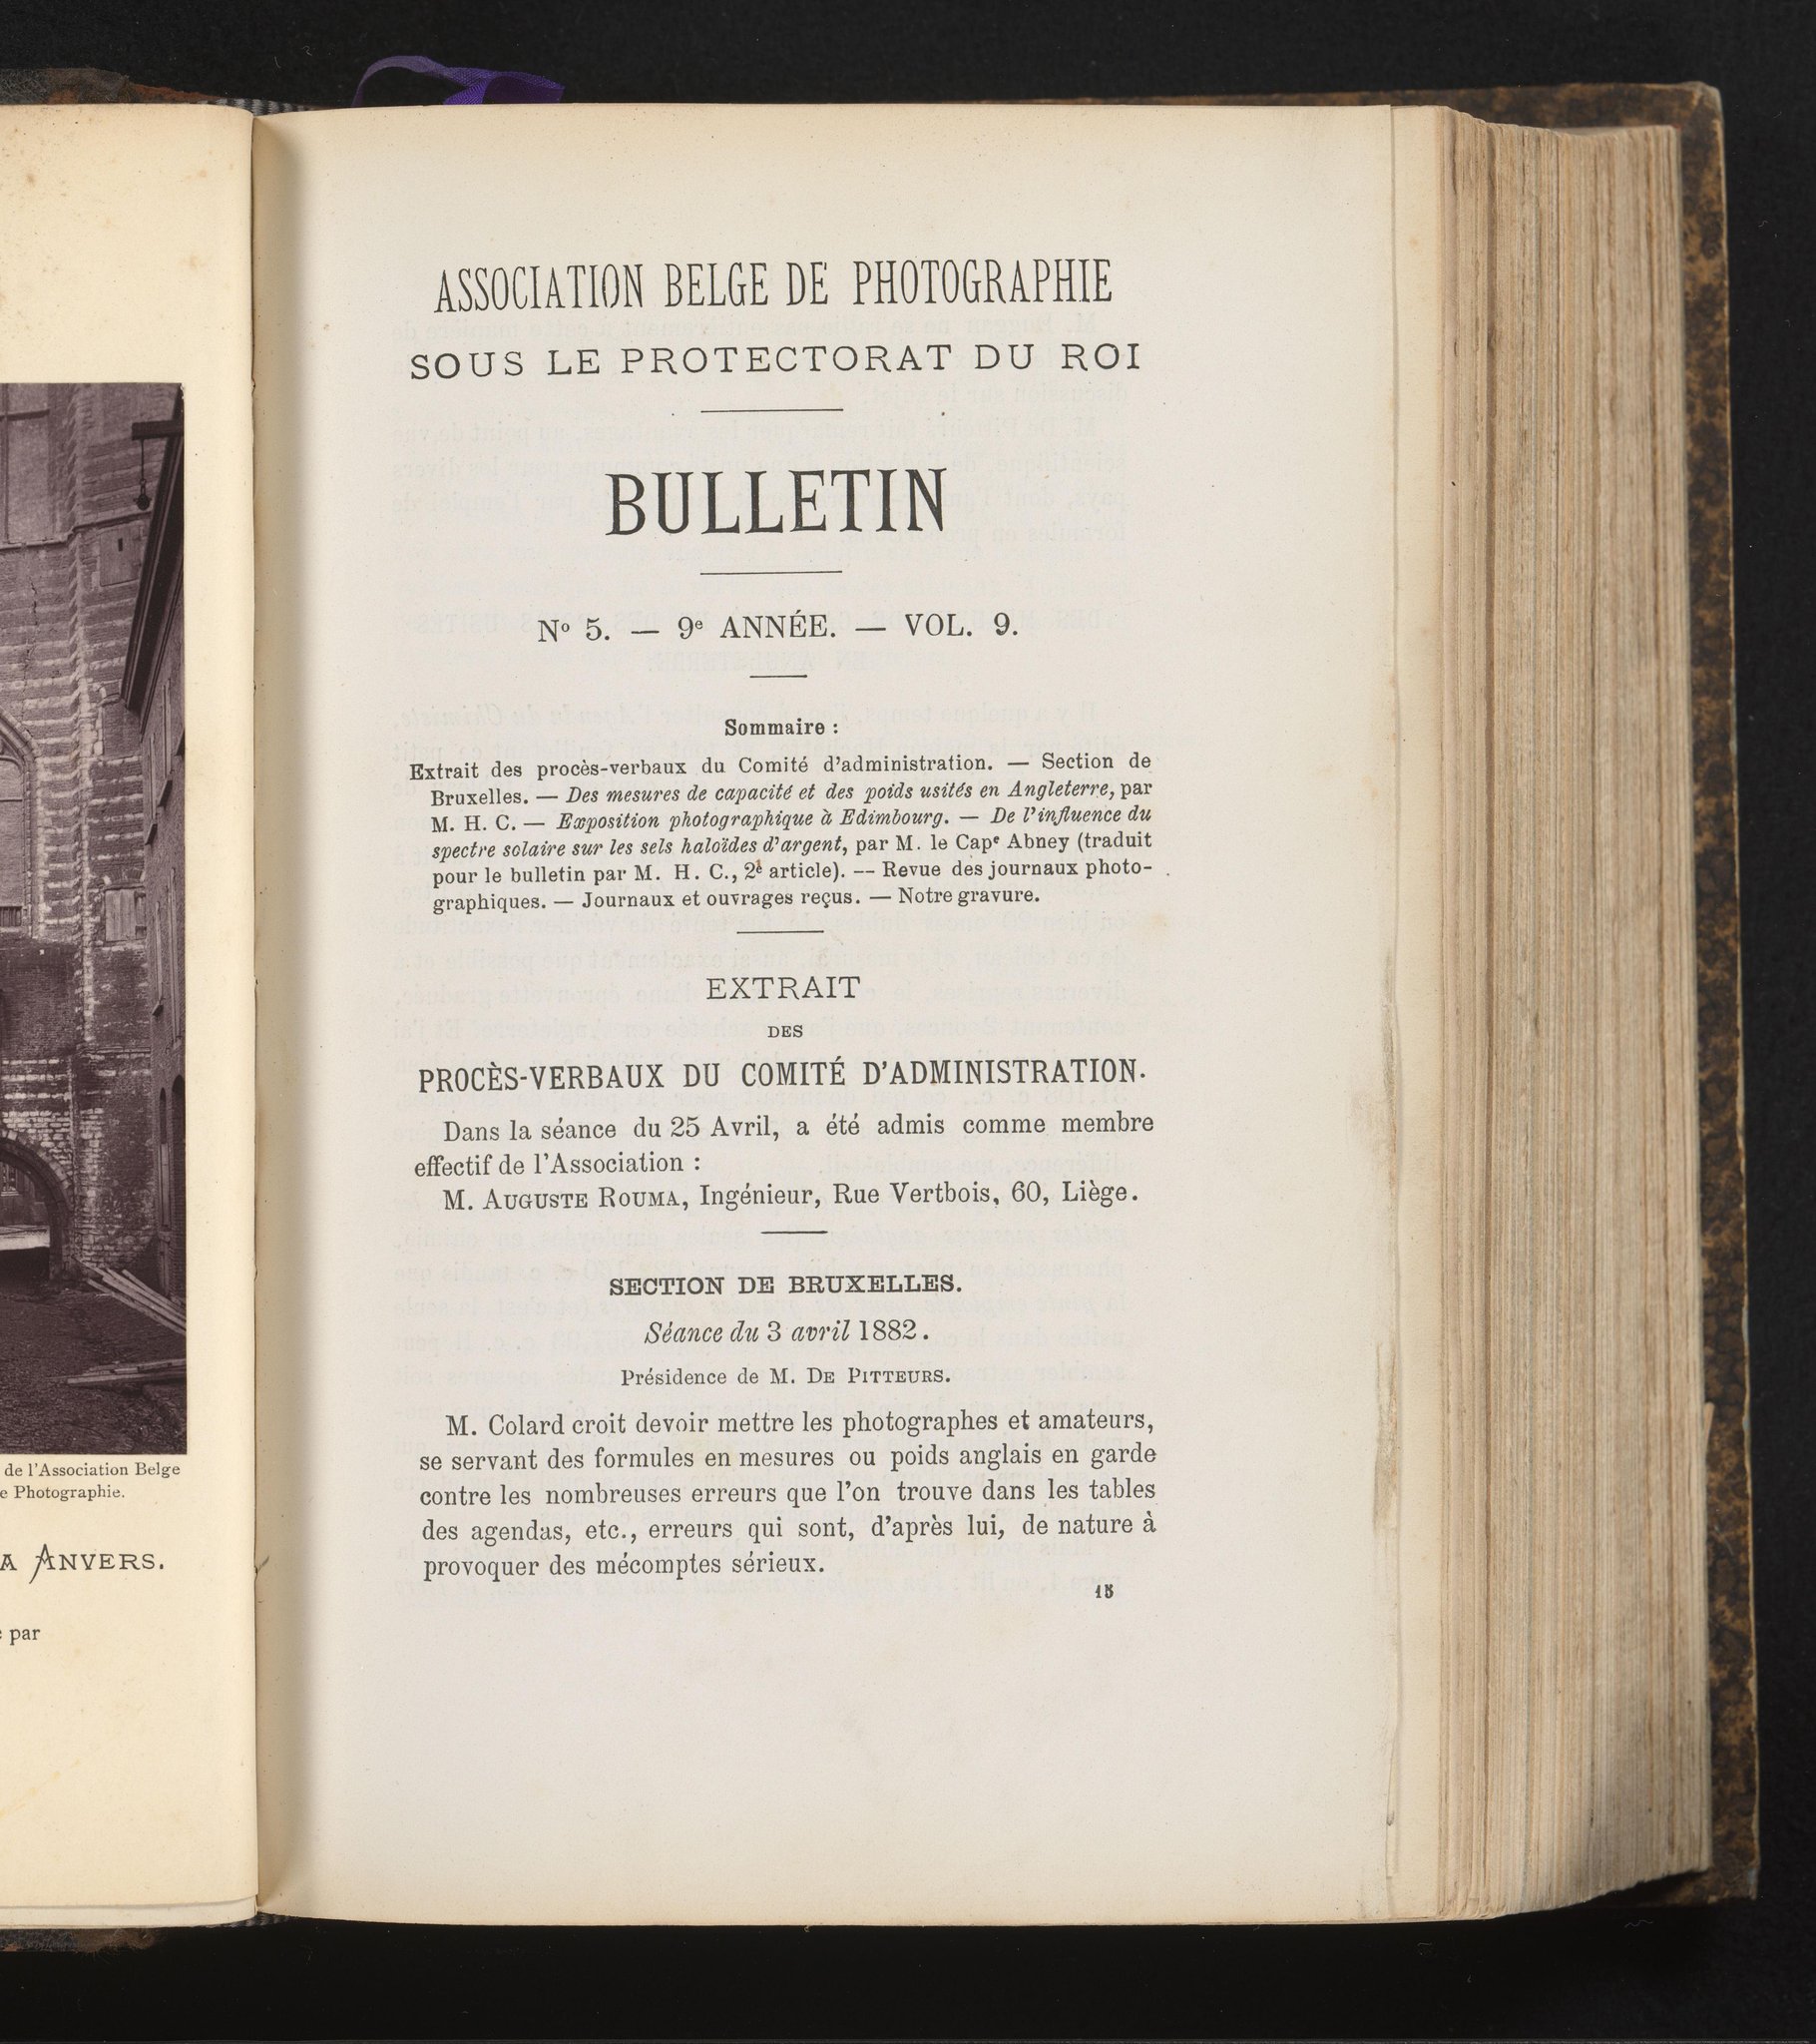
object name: photomechanical print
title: Gezicht op het Vleeshuis te Antwerpen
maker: joseph maes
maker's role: fotograaf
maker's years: 1838-1908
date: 1878-1883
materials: paper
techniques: woodburytype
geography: antwerp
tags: landscapes with waters, waterscapes, seascapes (in the temperate zone), civic architecture; edifices; dwellings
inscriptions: inscription: ‘Cliché avec plaque au Gelatino Bromure’, inscription: ‘Bulletin de l'Association belge de Photographie’